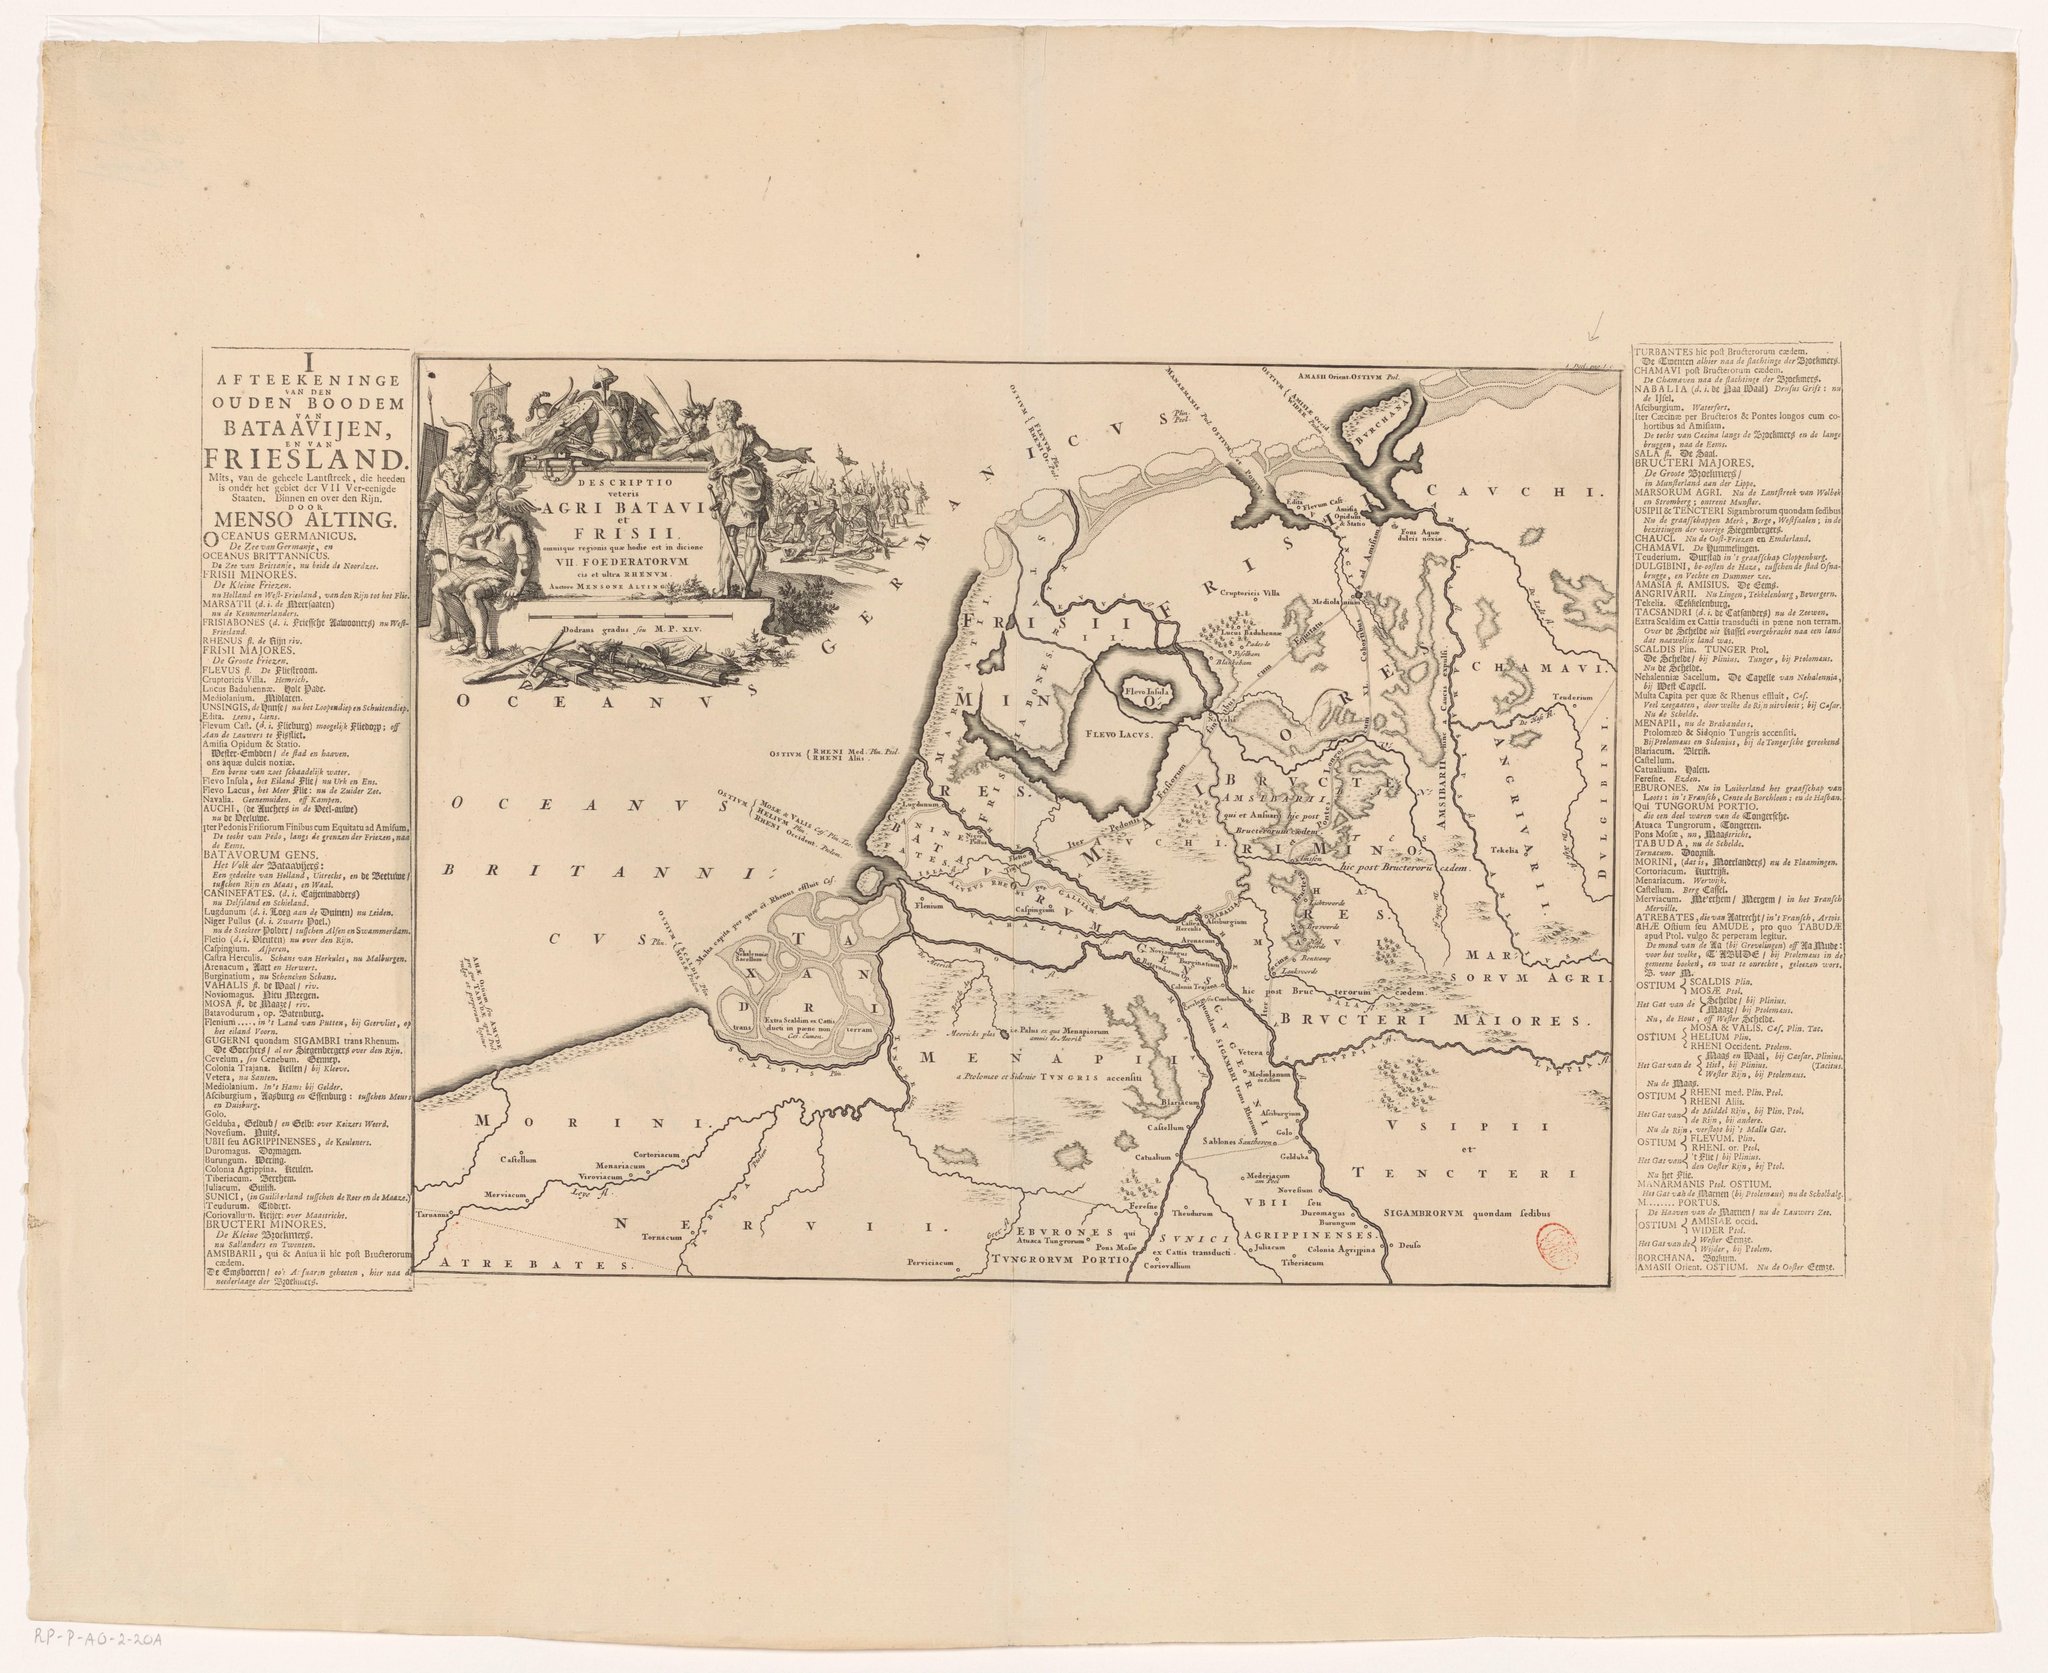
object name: map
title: Descriptio veteris agri Batavi et Frisii (...) / Afteekeninge van den ouden boodem van Bataavijen en van Friesland (...)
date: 1697-1700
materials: paper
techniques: engraving, etching, letterpress printing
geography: netherlands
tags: maps of separate countries or regions, netherlands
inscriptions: collector's mark: Lugt 2228, collector's mark: Lugt 195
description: Maakt deel uit van 16 kaarten van het land van de Bataven en de Friezen eerst vervaardigd voor en opgenomen in Alting, Menso. Descriptio, secundum antiquos, agri Batavi & Frisii. 2 delen. Amsterdam: Henricus Wetstein, 1697-1700. Hergebruikt in Halma, François. Tooneel der Vereenigde Nederlanden, en onderhorige landschappen (...). 2 delen. Leeuwarden: Hendrik Halma, 1725. Een deel van deze kaarten, waaronder dit exemplaar, is ook gebruikt in Schotanus à Sterringa, Bernardus. Uitbeelding der Heerlijkheit Friesland. Zoo int algemeen, als in haare XXX bijzondere grietenijen (...). Leeuwarden: François Halma, 1718. Deze kaart is gebruikt in Halma's Tooneel der Vereenigde Nederlanden (1725) en is waarschijnlijk te vinden in deel 1, p. 1c.